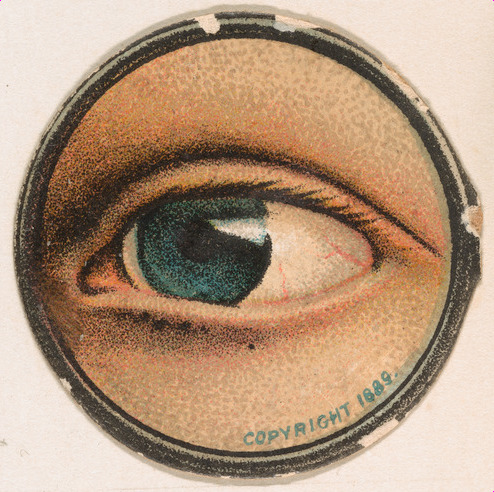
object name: print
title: Monocle and Eye (blue), from Jocular Ocular series (N221) issued by Kinney Bros.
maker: kinney brothers tobacco company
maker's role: publisher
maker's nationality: american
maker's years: 1869-2011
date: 1889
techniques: color lithograph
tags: eyes